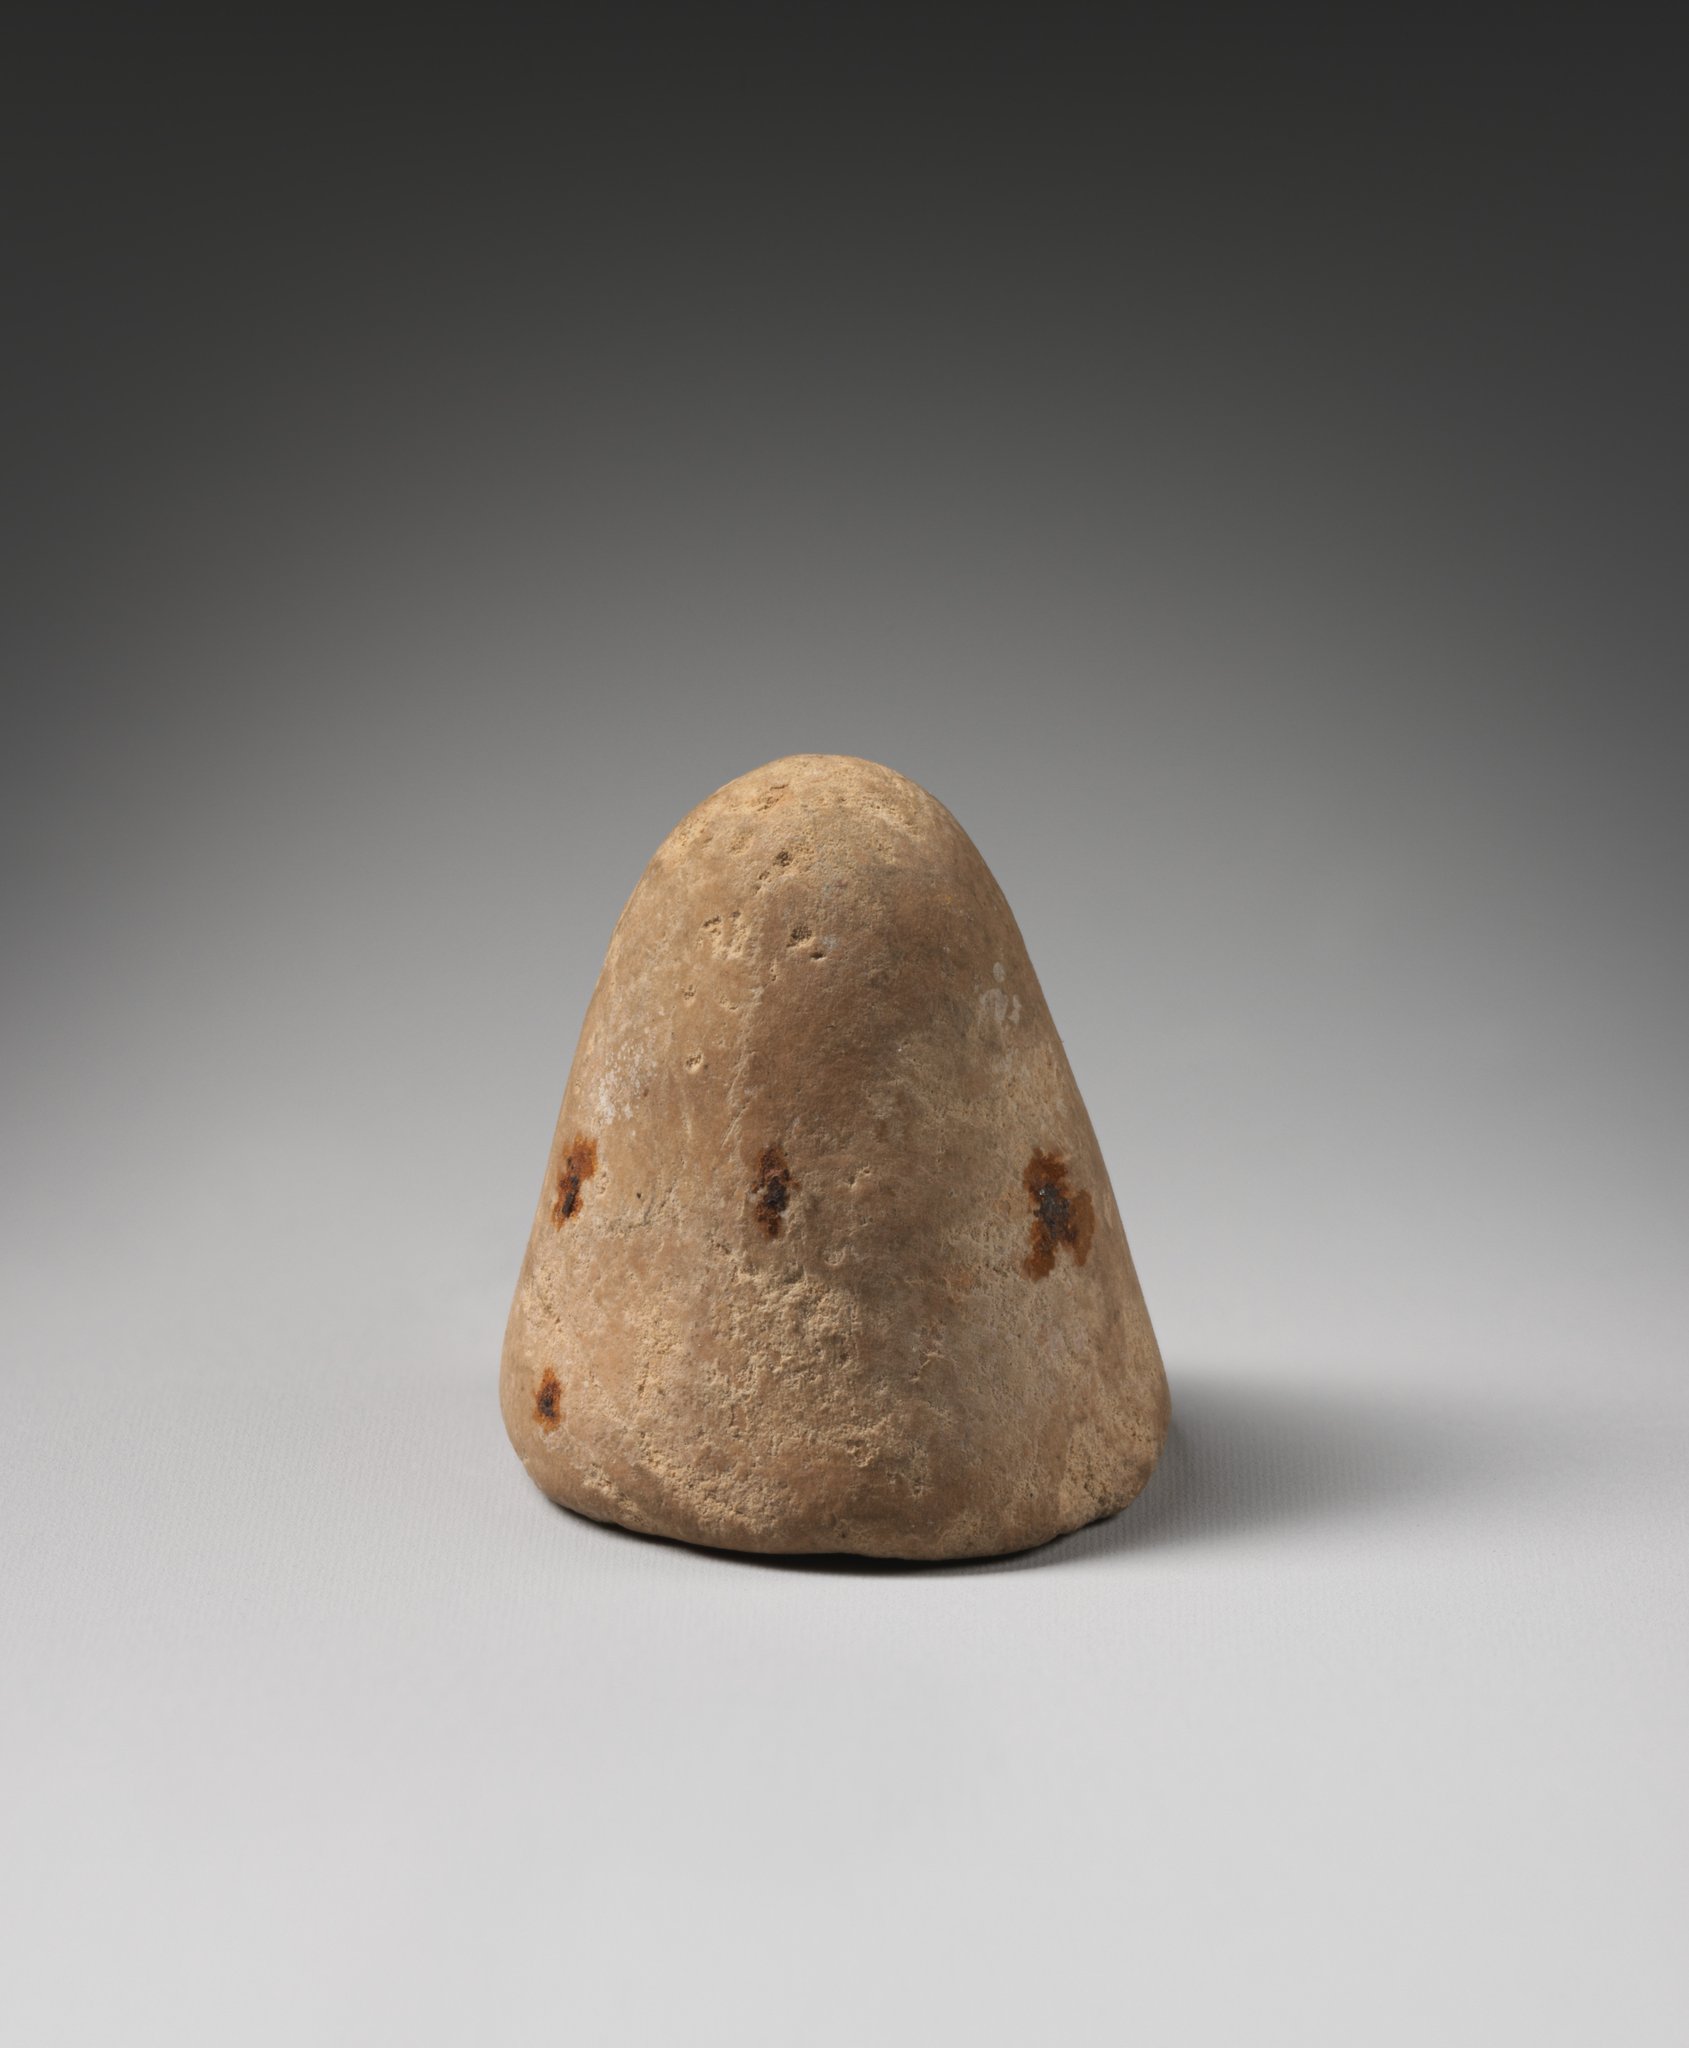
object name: chessman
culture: sasanian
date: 201-700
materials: ceramic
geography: iran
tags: chess,games